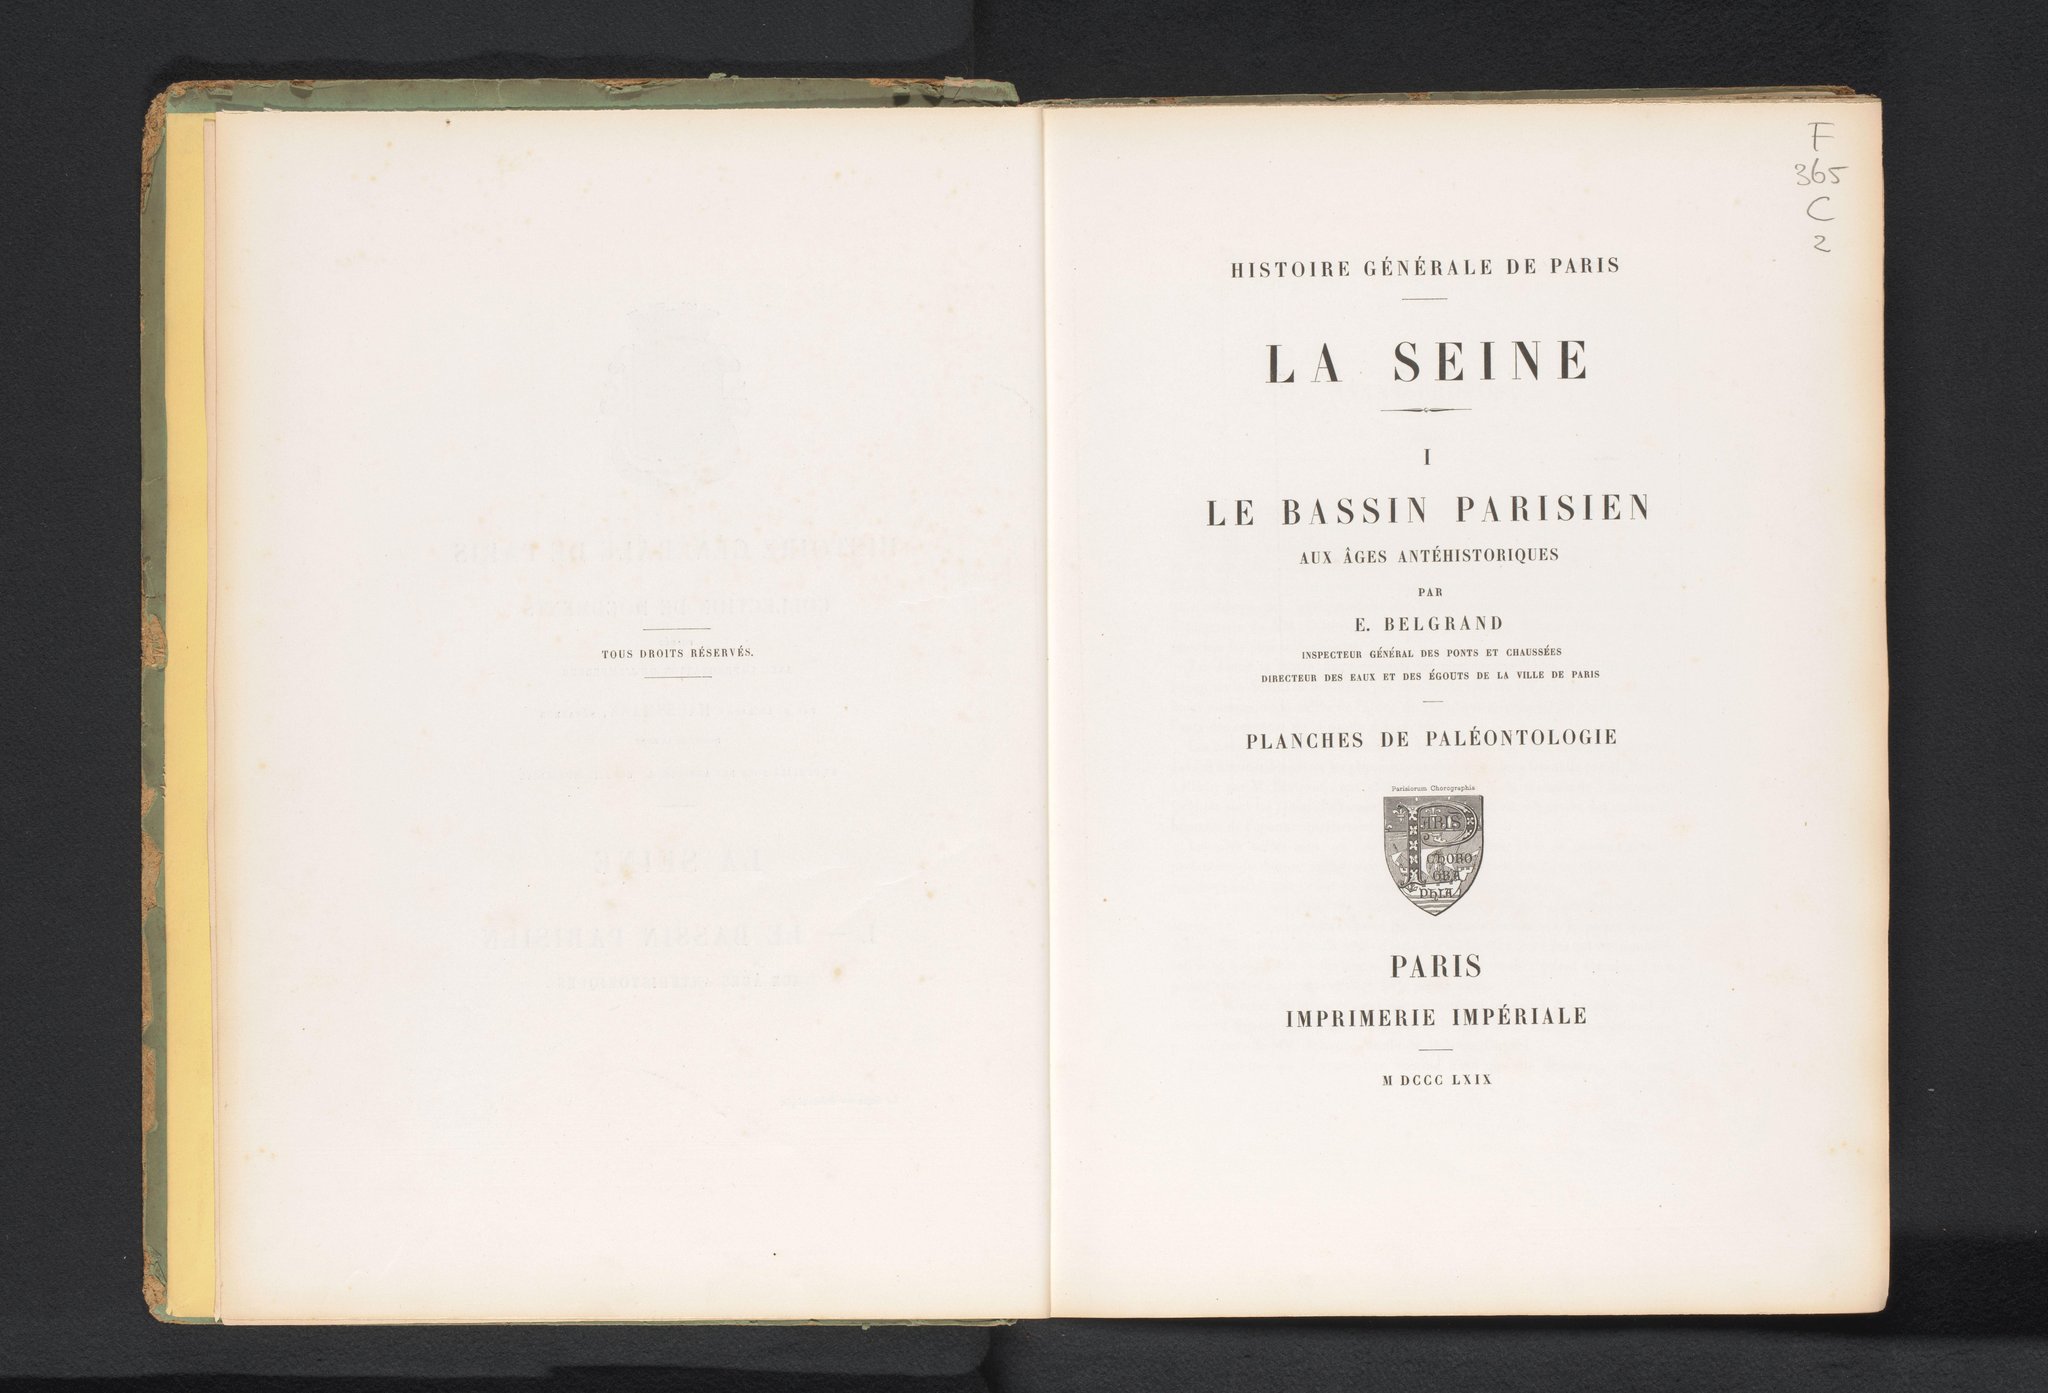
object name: book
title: La Seine : I. Le bassin parisien aux âges anthéhistoriques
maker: eugène belgrand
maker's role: engineer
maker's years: 1810-1878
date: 1869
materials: cardboard, leather, linen, paper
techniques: photoaquatint, photolithography, printing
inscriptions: date: ‘OCT 1998’